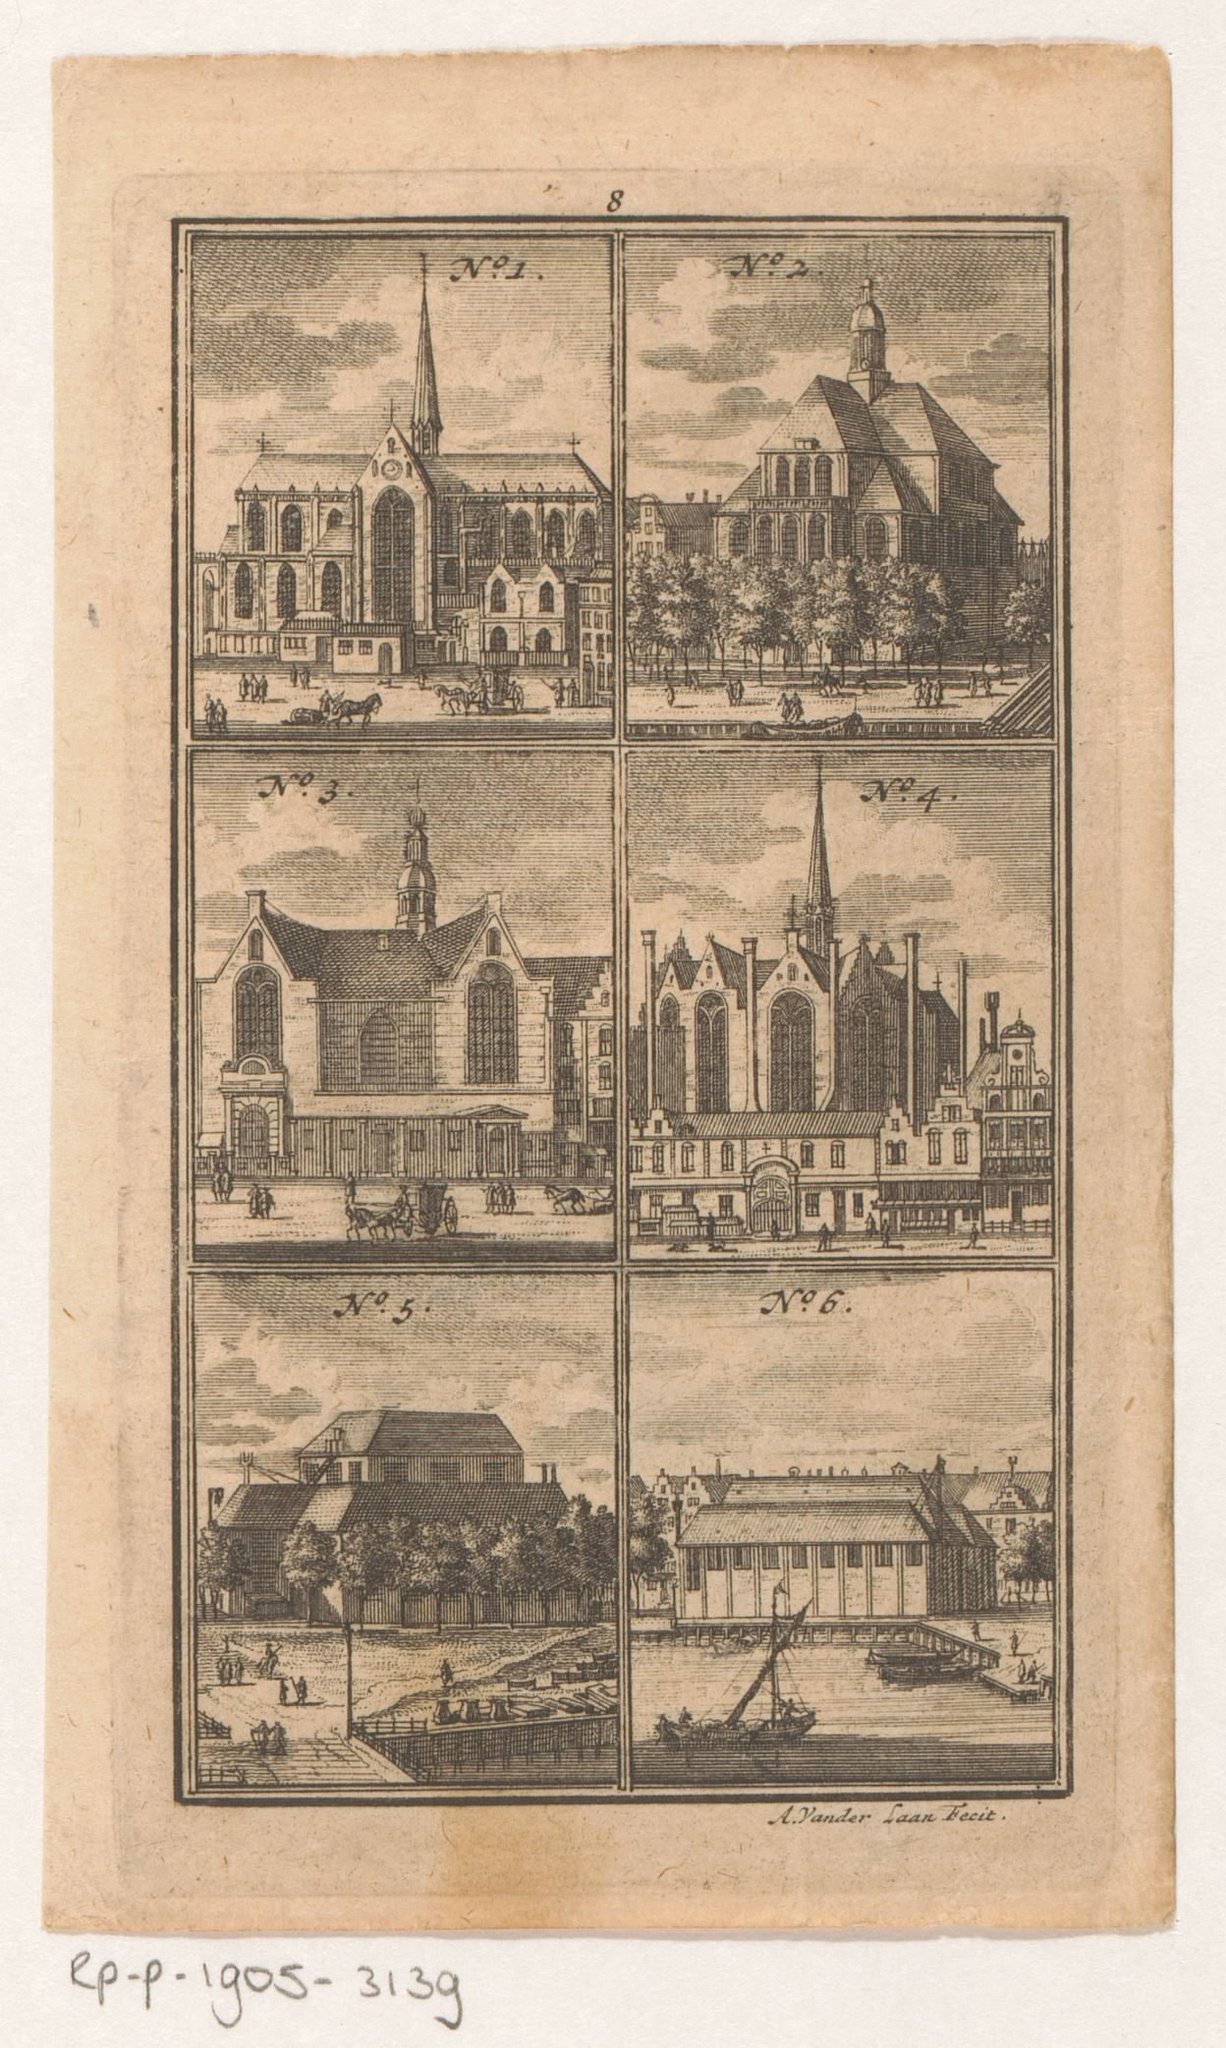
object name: print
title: Zes verschillende kerken en kapellen te Amsterdam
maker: adolf van der laan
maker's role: draughtsman, print maker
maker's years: 1689-1742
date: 1723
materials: paper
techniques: etching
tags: church (exterior), civic architecture; edifices; dwellings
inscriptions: collector's mark: Lugt 2228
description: Zes genummerde illustraties van kerken en kapellen te Amsterdam: Nieuwe Kerk, Oosterkerk, Oudezijdskapel, Nieuwezijds Kapel, Amstelkerk, Eilandskerk. De kerken zijn op het bijbehorende tekstblad voorzien van toelichting. Prent middenboven genummerd: 8.